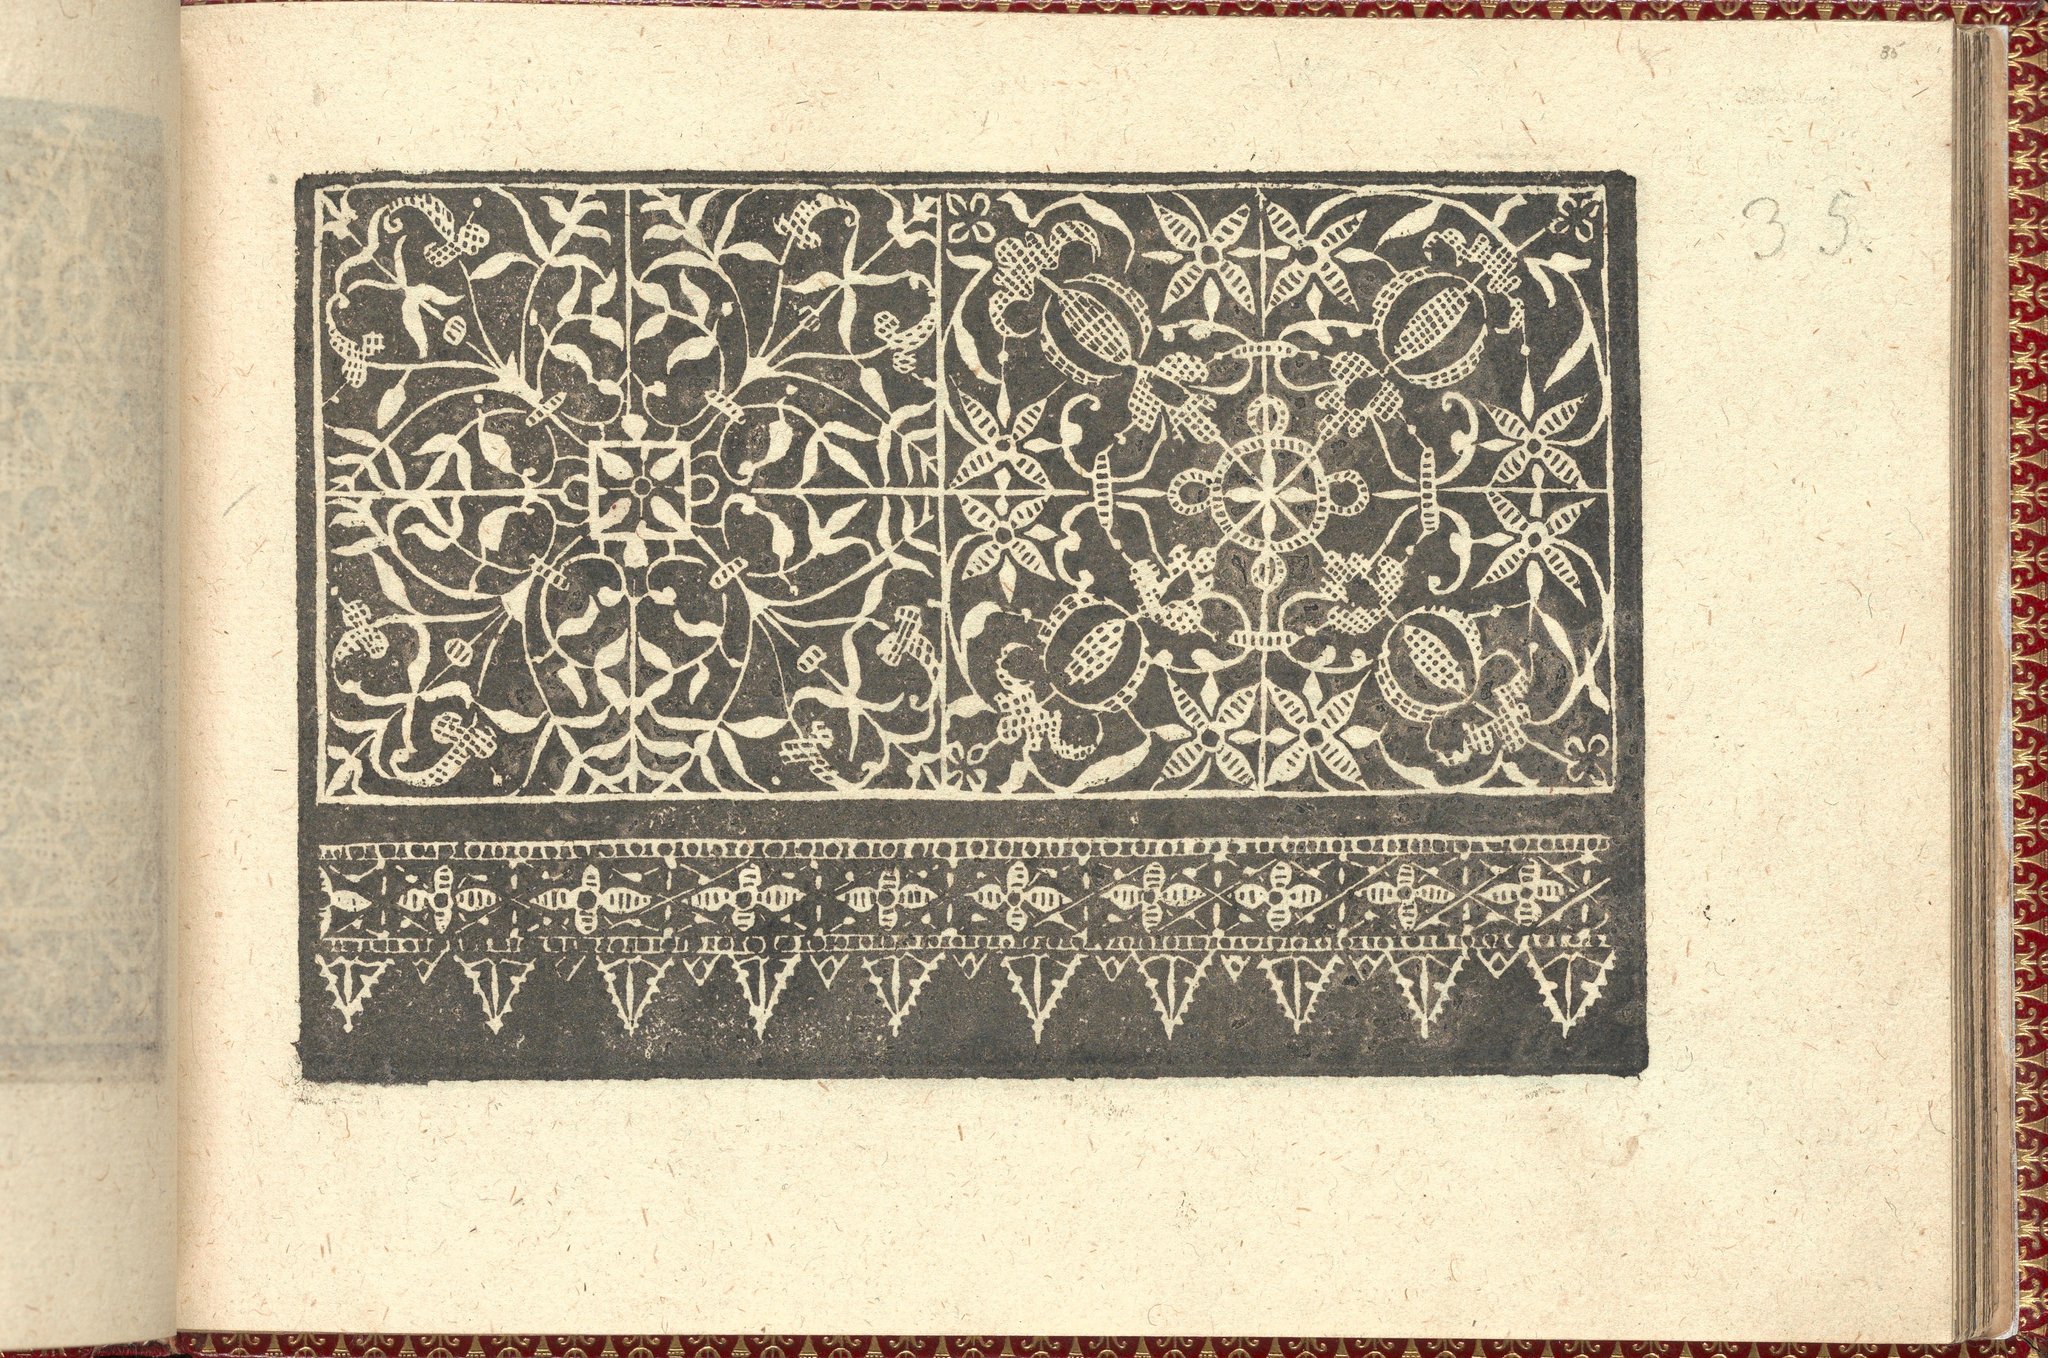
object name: book print ornament architecture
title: Corona delle Nobili et Virtuose Donne: Libro I-IV, page 35 (recto)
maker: cesare vecellio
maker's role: publisher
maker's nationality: italian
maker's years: 1521-1601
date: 1601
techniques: woodcut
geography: italy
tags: ornament